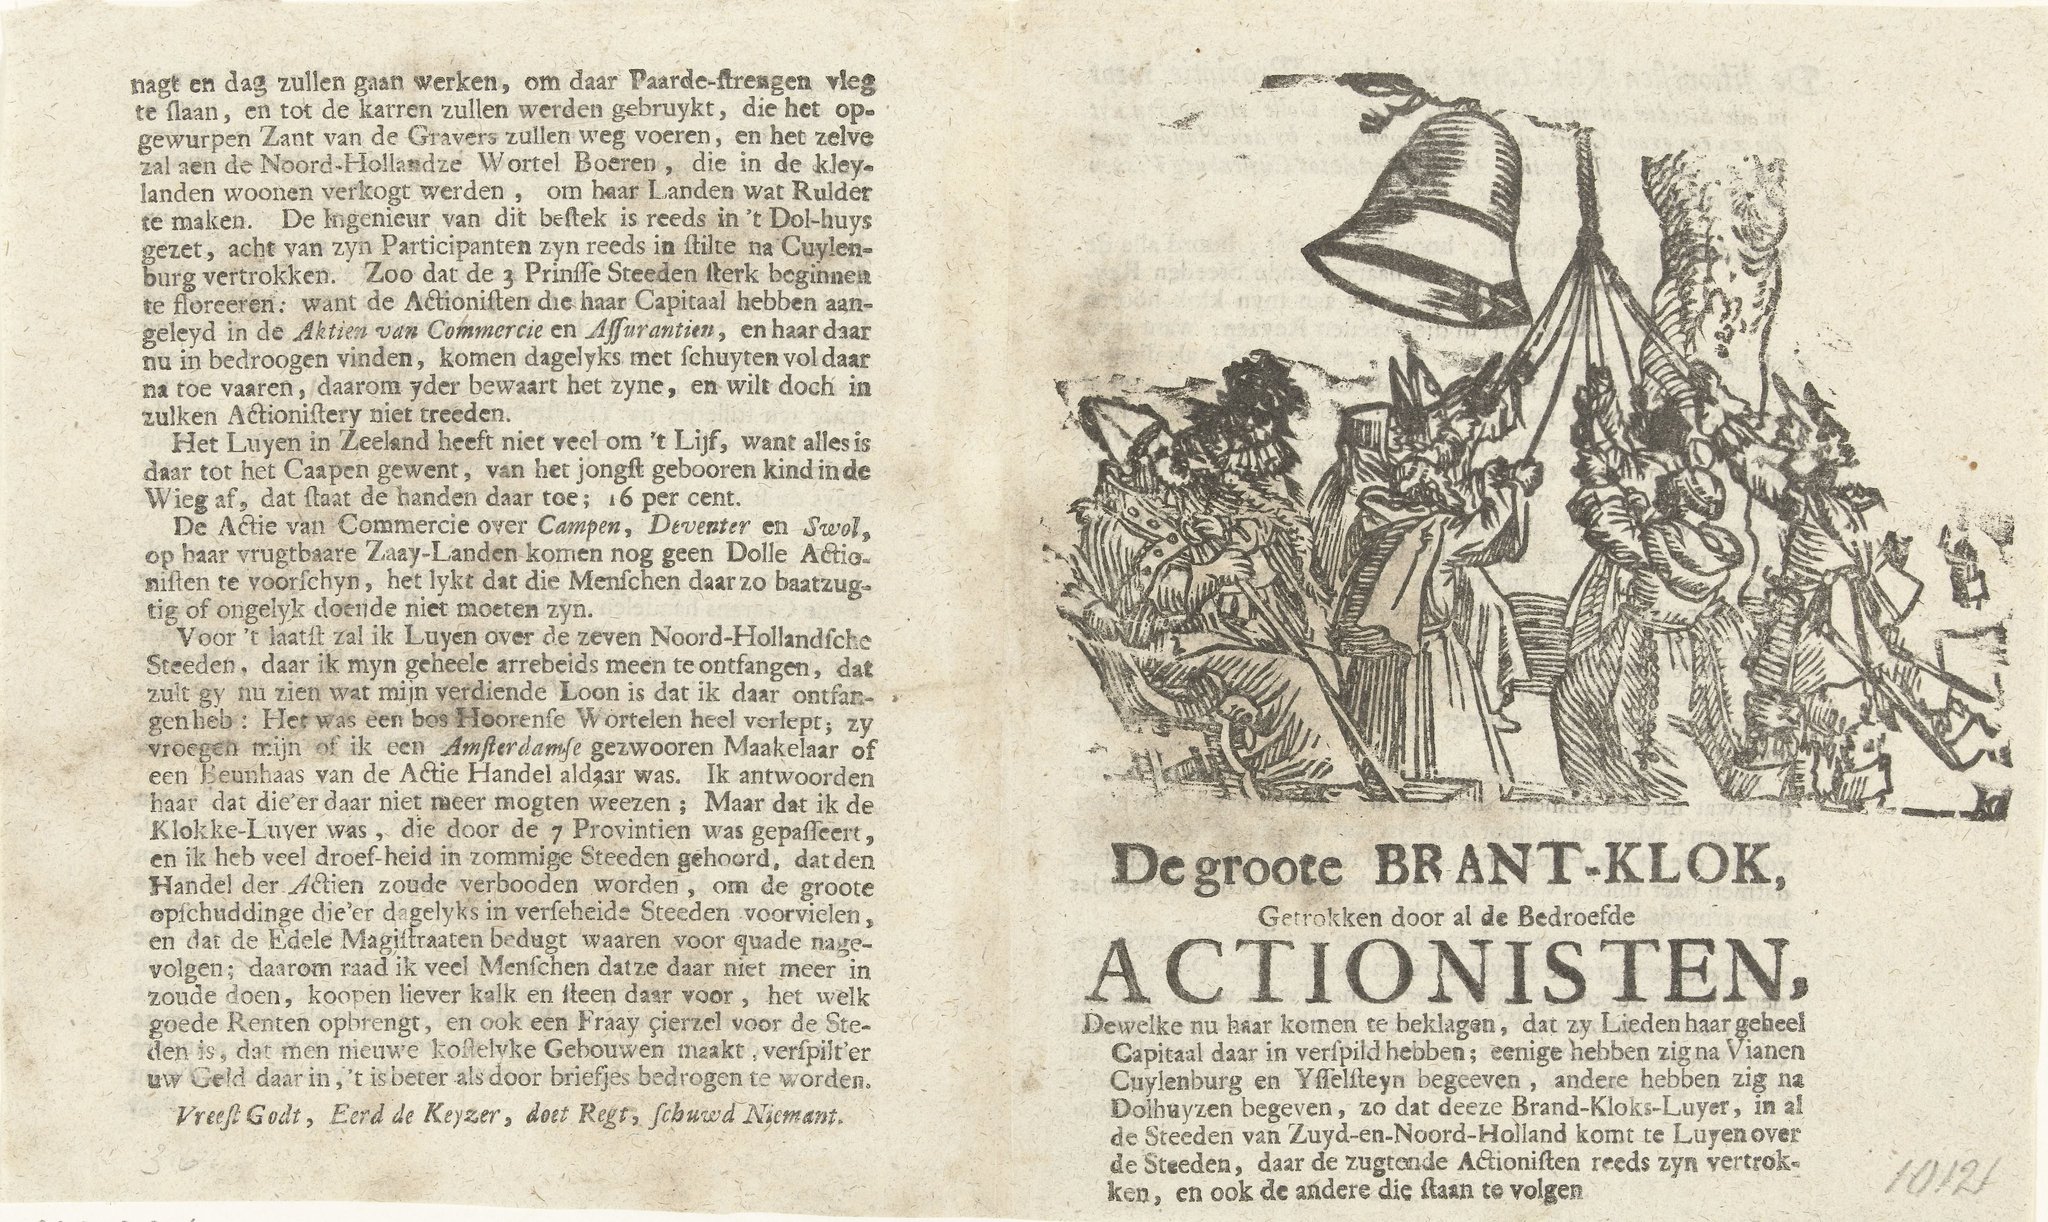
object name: pamphlet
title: De groote Brant-Klok, Getrokken door al de Bedroefde Actionisten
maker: Anonymous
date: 1720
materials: paper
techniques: letterpress printing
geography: northern netherlands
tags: church bell, bell ~ acoustic signalling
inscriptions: collector's mark: Lugt 2228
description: Pamflet van een dubbelgevouwen blad bedrukt op alle vier bladzijden met tekst over de windhandel van 1720. Op de voorzijde een voorstelling van het luiden door roomse geestelijken en militairen van een grote klok die aan een boom hangt. Links kijkt een bisschop zittend in een stoel toe. Behoort tot de groep van bijprenten toegevoegd aan de serie Tafereel der Dwaasheid met spotprenten op de Windhandel of Actiehandel van 1720.